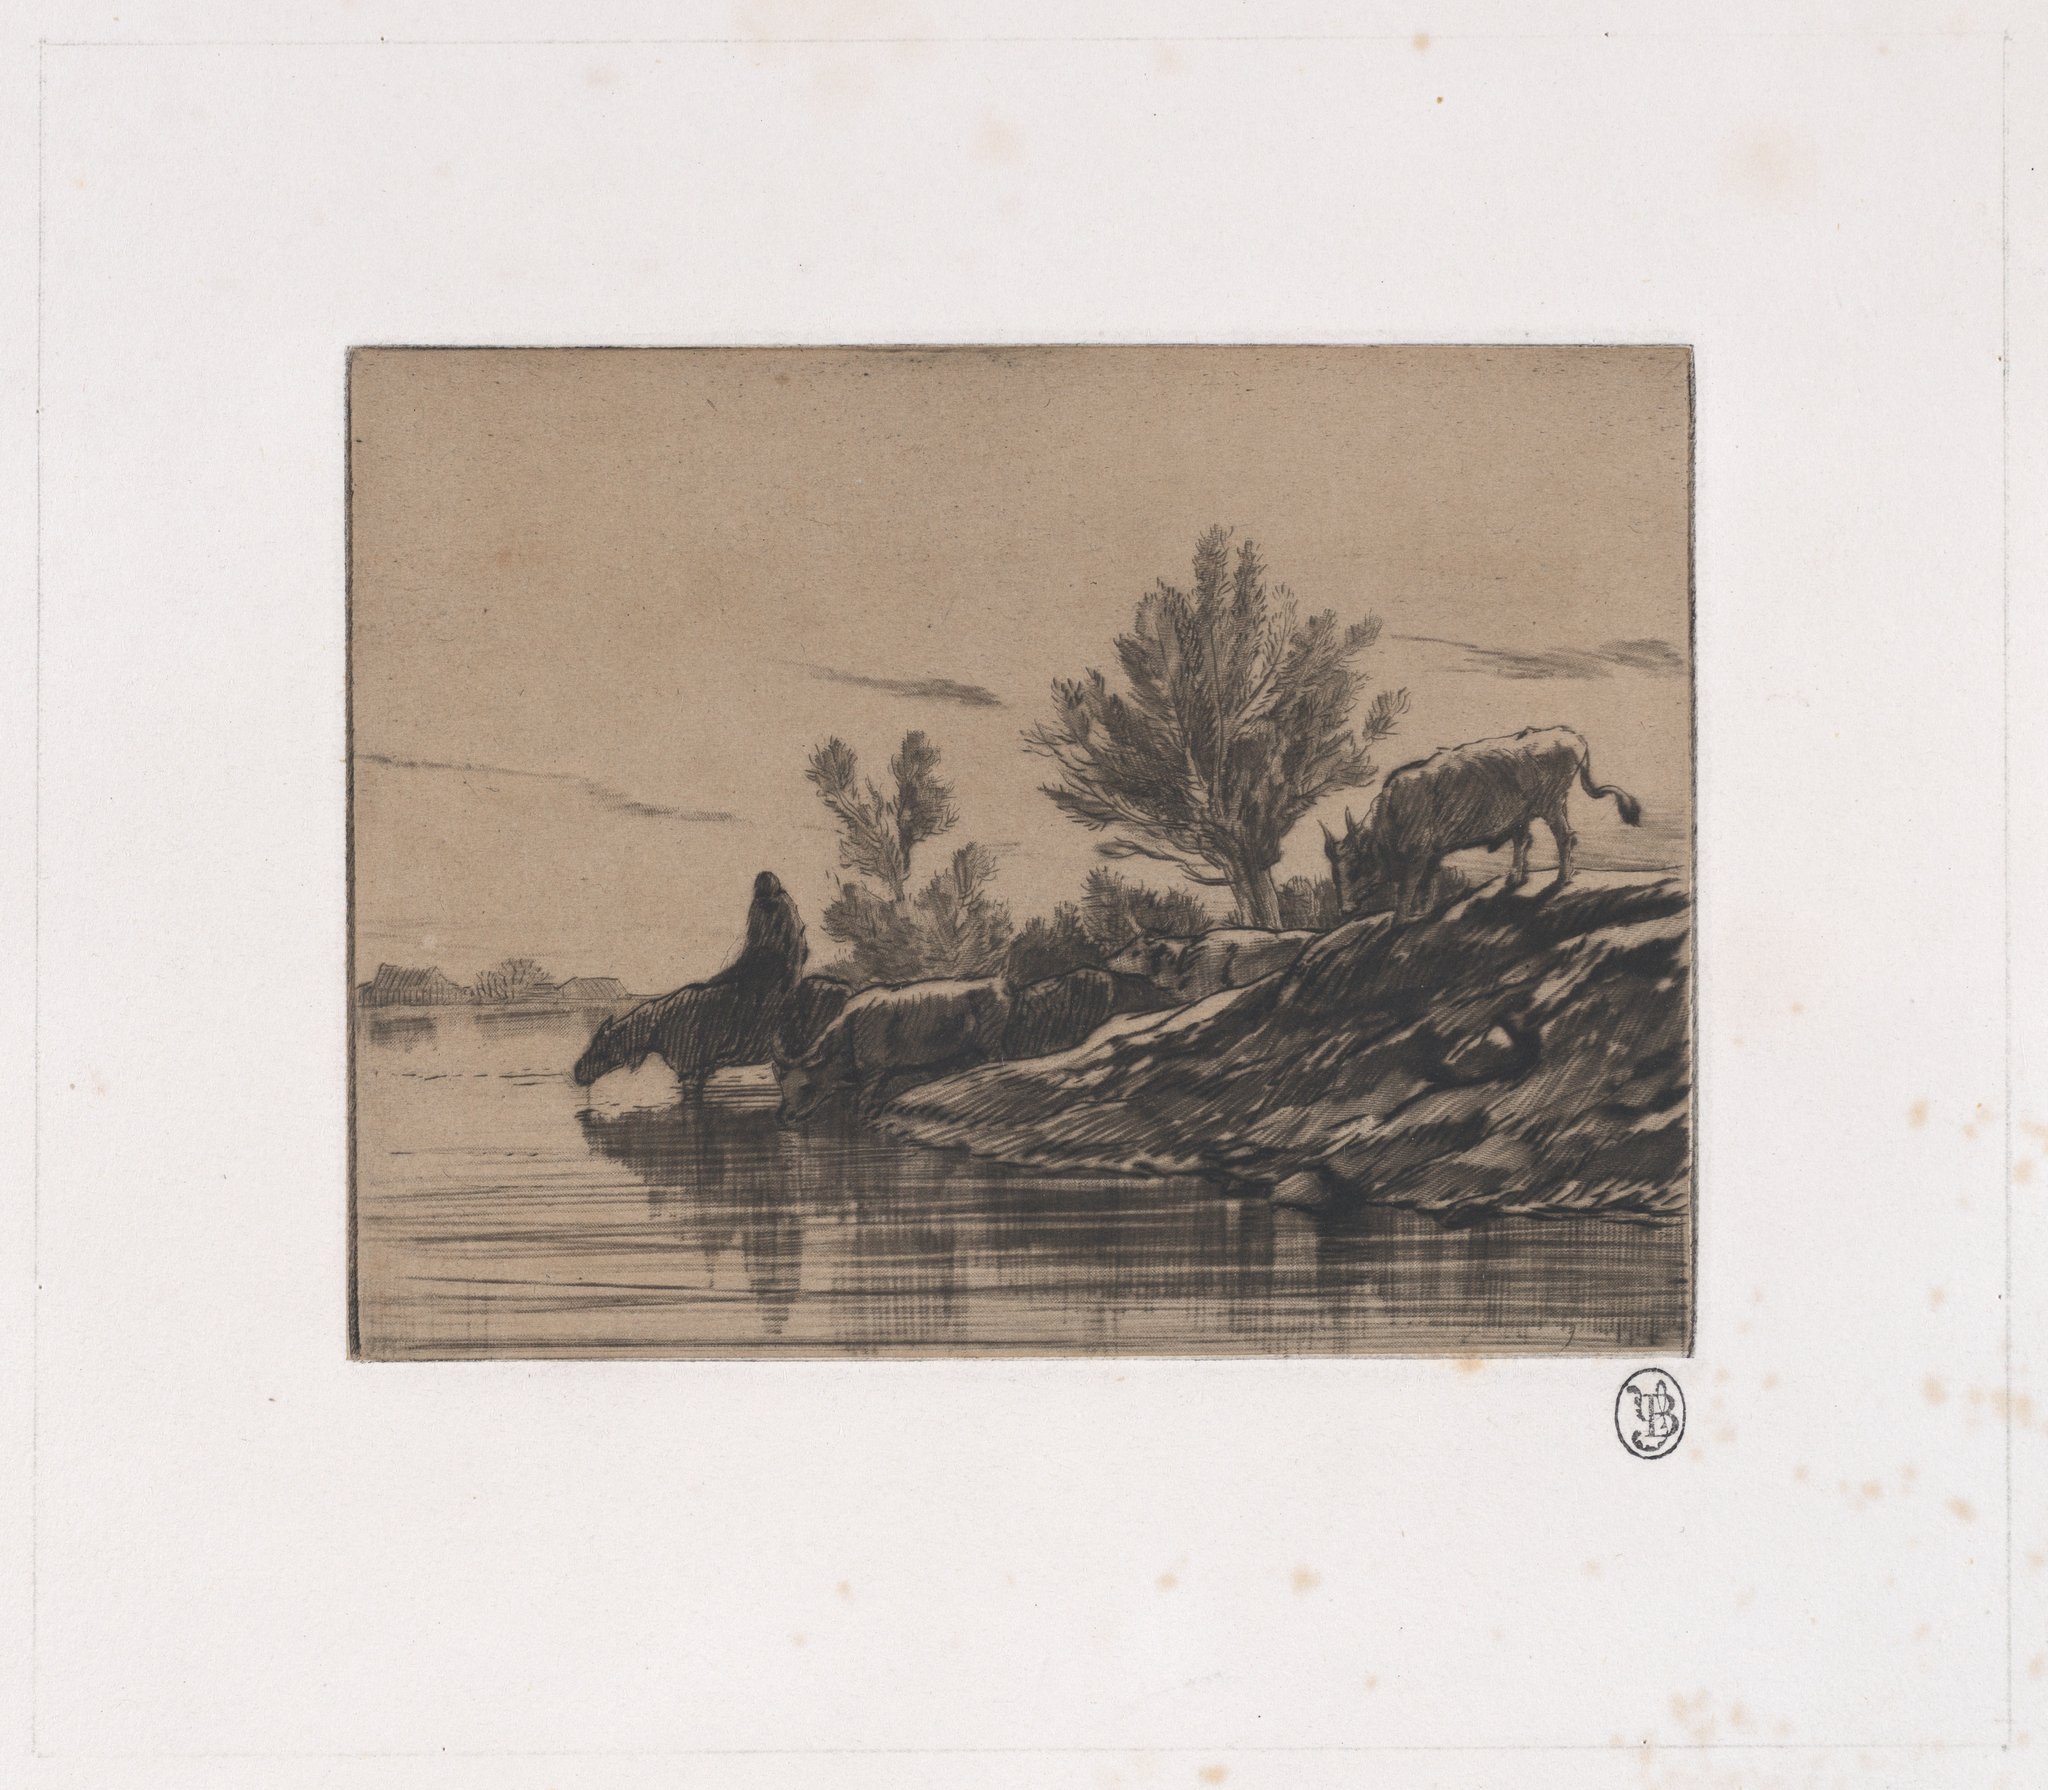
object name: print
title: The Watering Hole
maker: charles émile jacque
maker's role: artist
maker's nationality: french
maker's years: 1813-1894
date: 1848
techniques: printmaking, drypoint